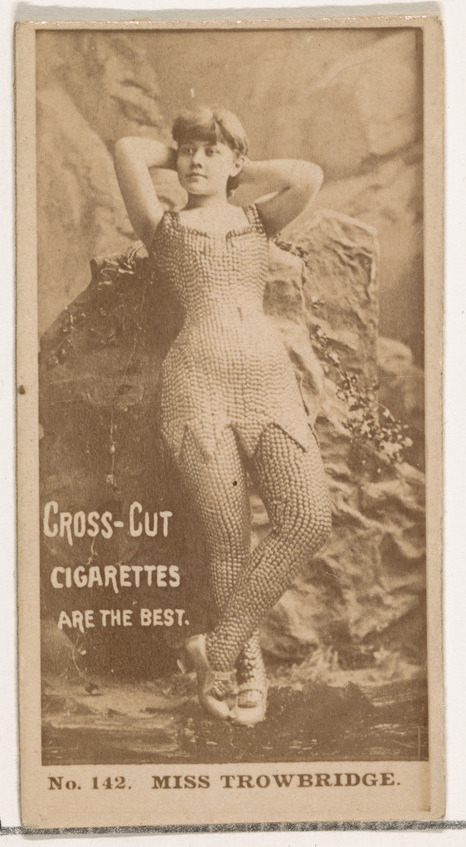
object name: print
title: Card Number 142, Miss Trowbridge, from the Actors and Actresses series (N145-2) issued by Duke Sons & Co. to promote Cross Cut Cigarettes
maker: w. duke, sons & co.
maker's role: publisher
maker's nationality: american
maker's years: 1870-1920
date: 1880-1889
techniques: albumen silver print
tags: portraits,women,actresses